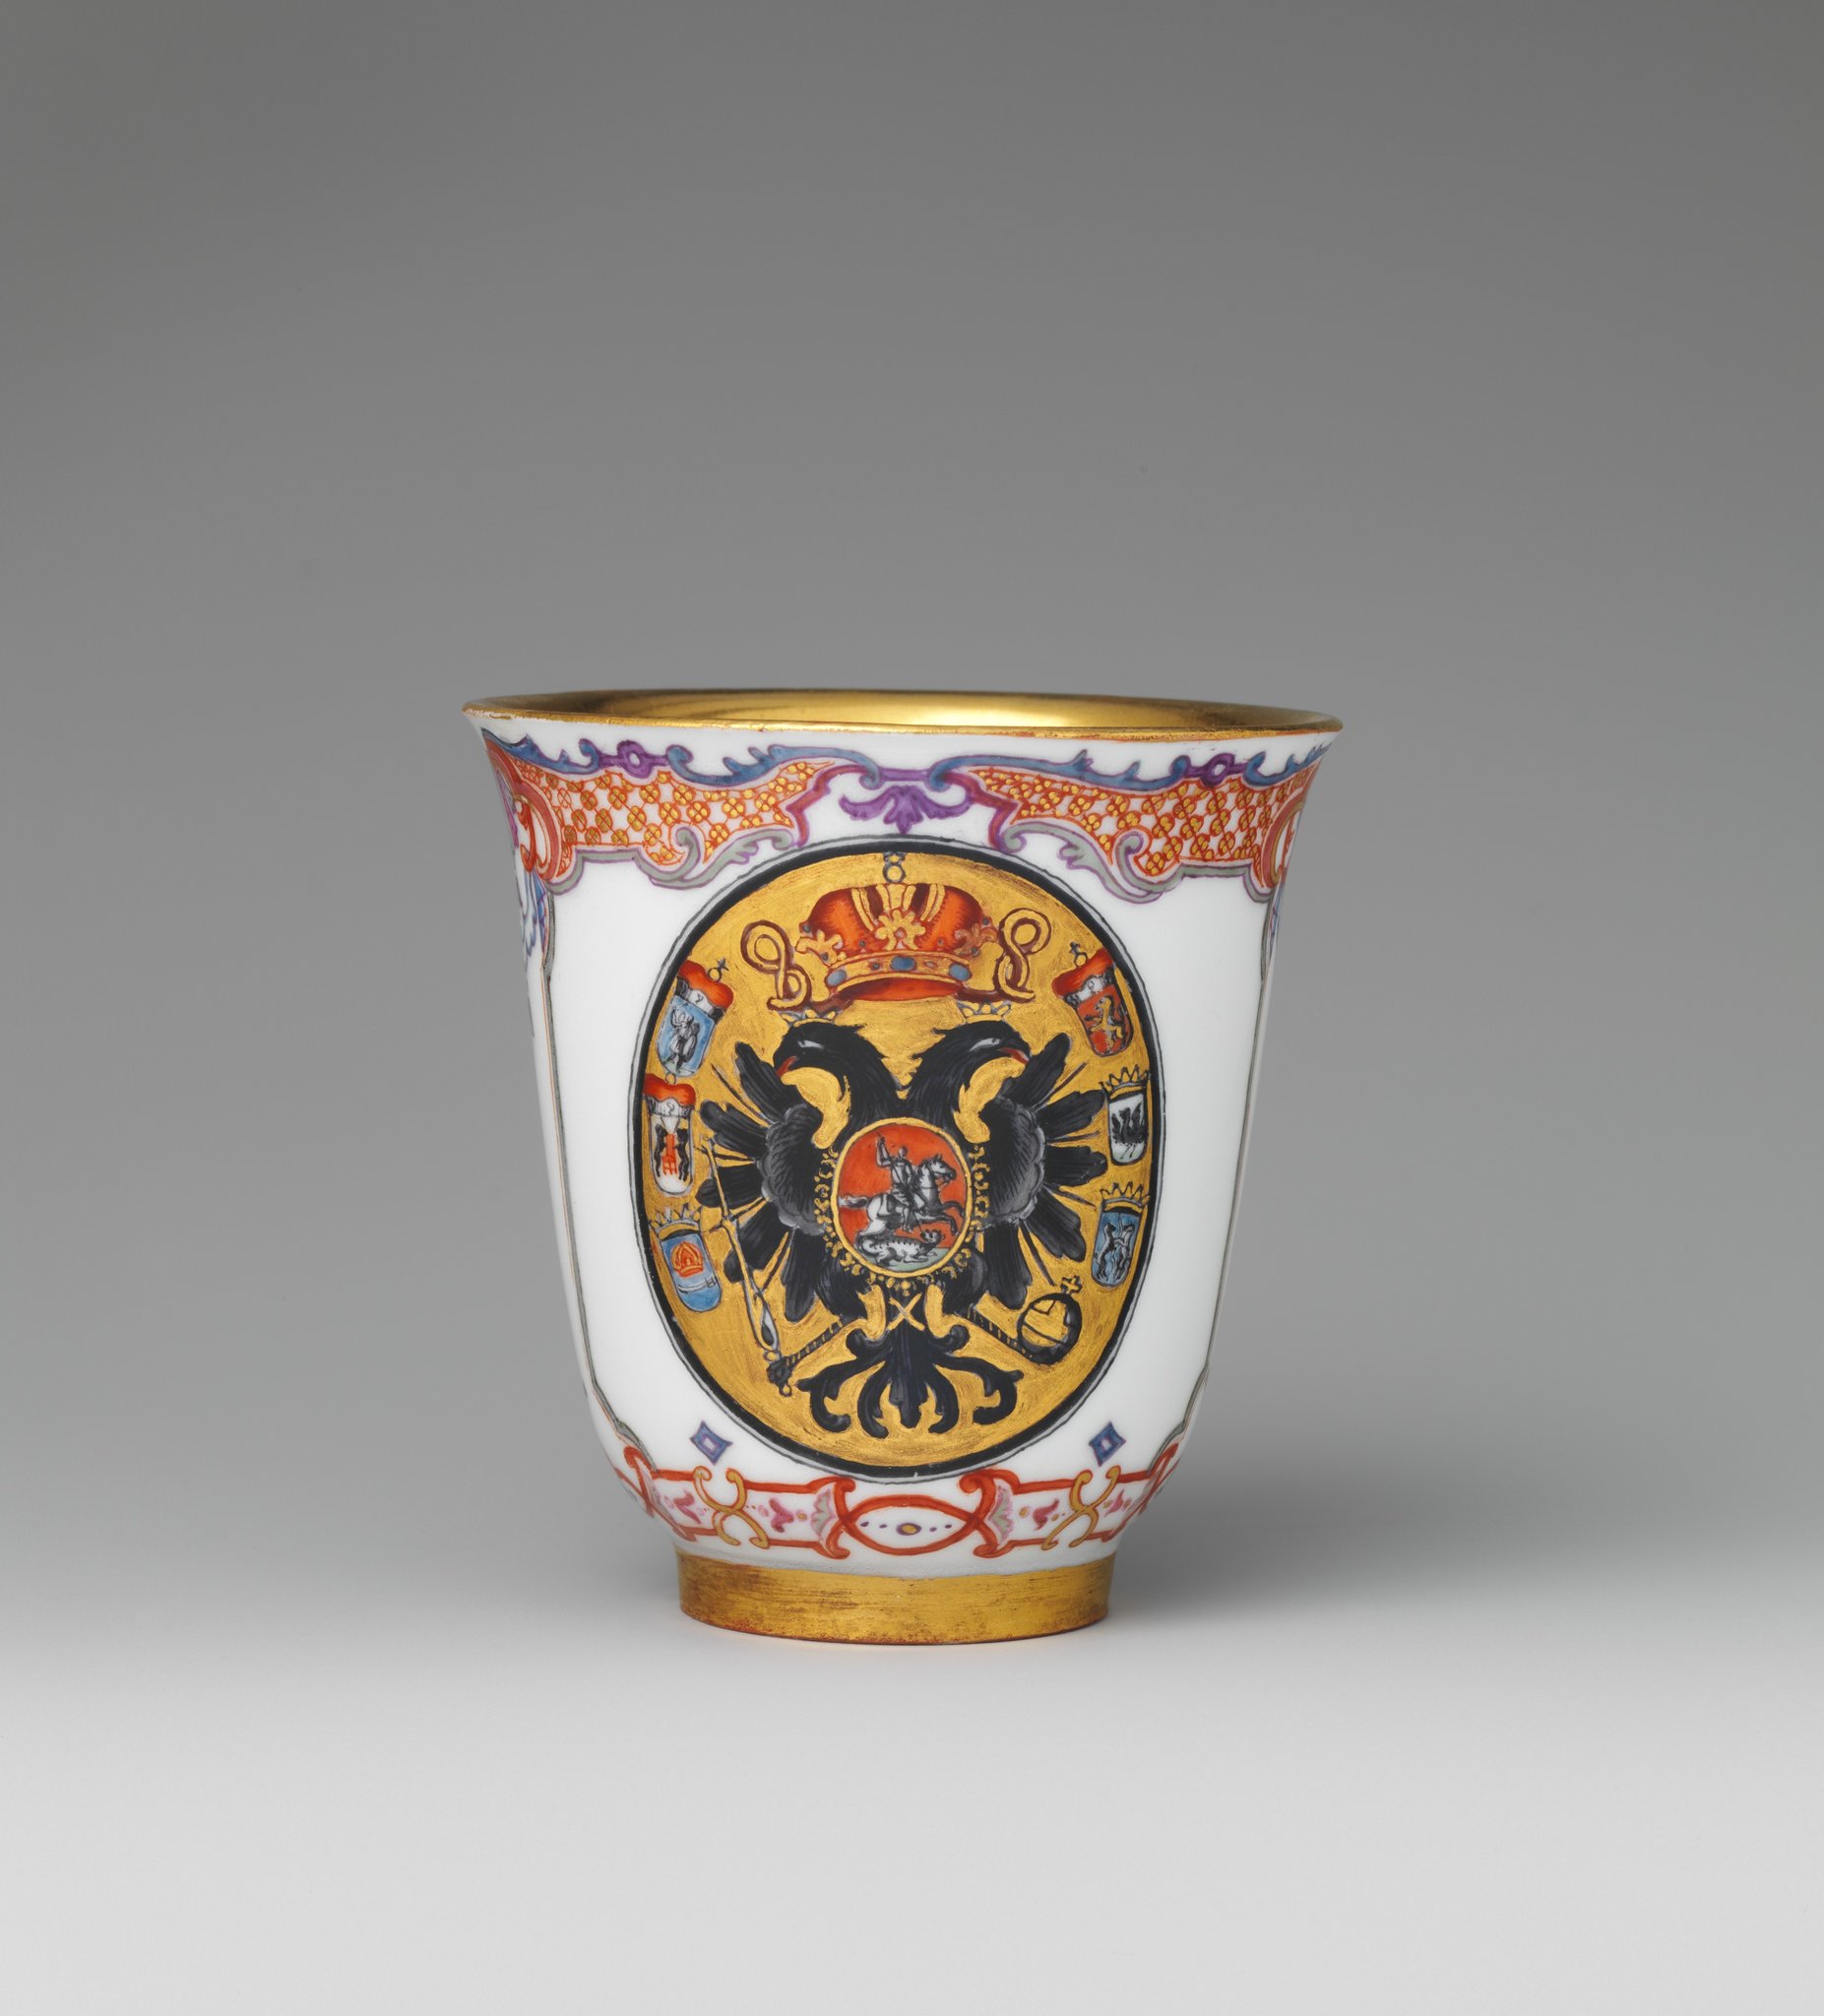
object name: beaker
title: Beaker with Imperial Russian Arms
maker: vienna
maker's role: manufactory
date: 1735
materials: hard paste porcelain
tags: eagles,coat of arms